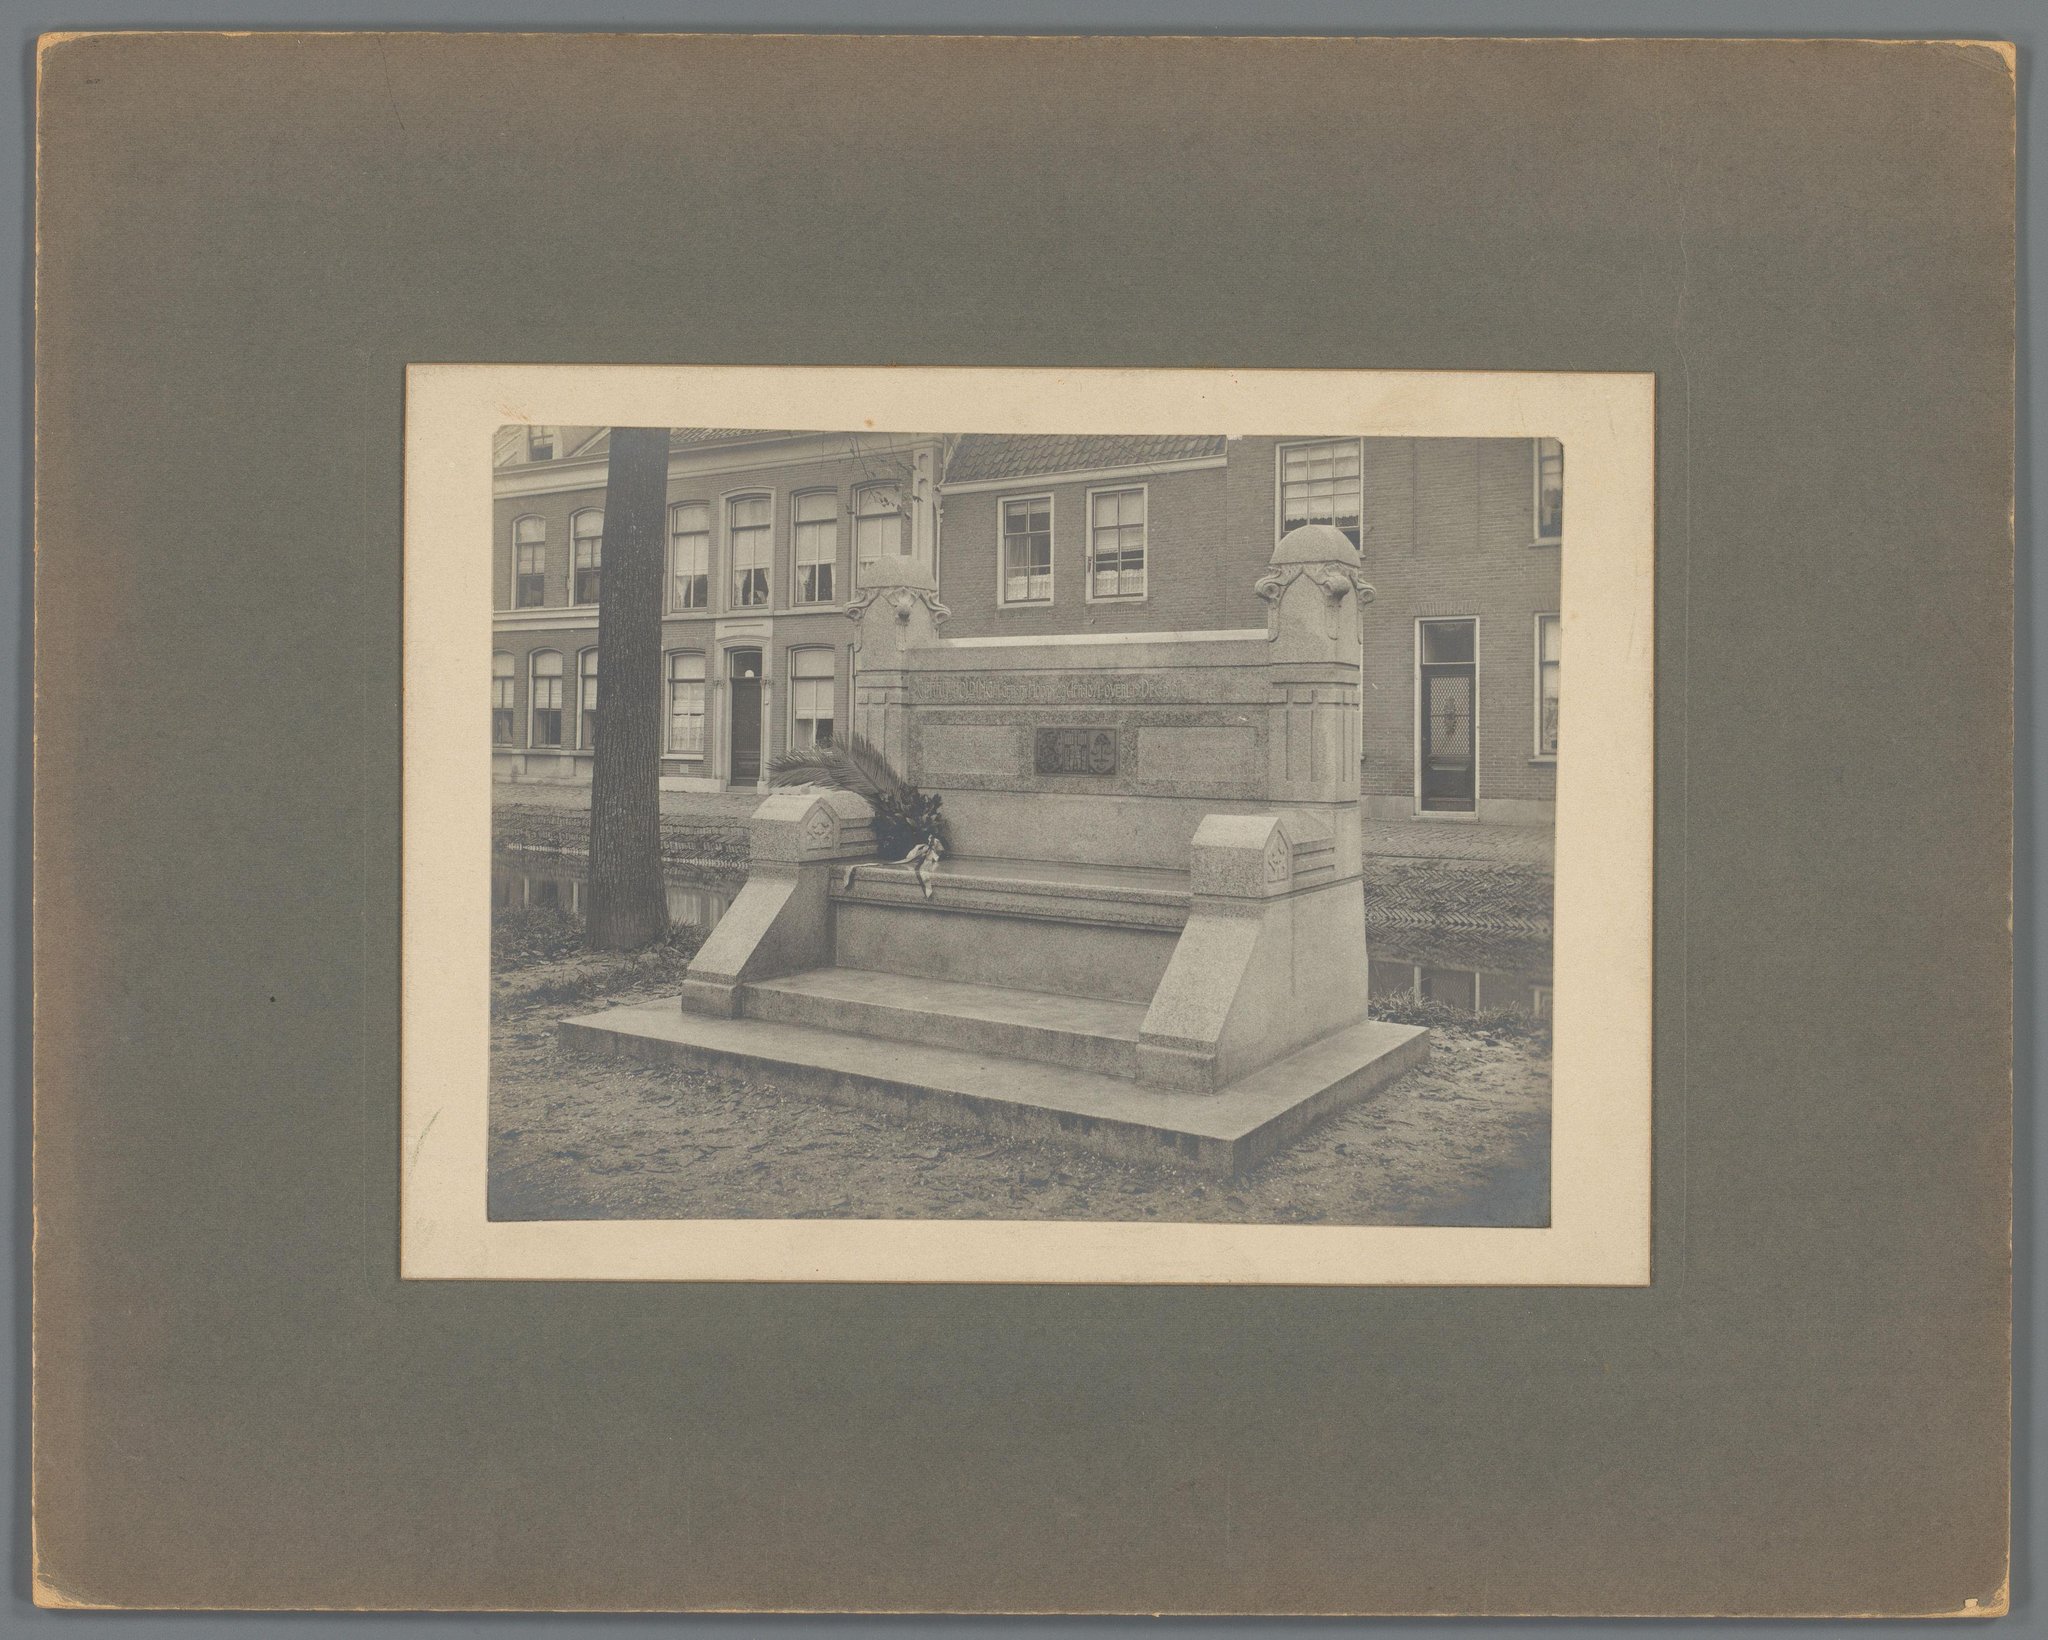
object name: photograph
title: Herdenkingsbank voor Gerrit Boldingh (1871-1901) op het Kazerneplein, Gorinchem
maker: Anonymous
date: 1903-1917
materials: paper, cardboard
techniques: gelatin silver print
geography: gorinchem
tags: bench, monument, statue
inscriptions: inscription: ‘Gerrit Boldingh/ geb. te Hoorn 22 April 1871/ + 19 Dec. 1901’, stamp: ‘[Ams]terdam/ 25/ 8-9N’